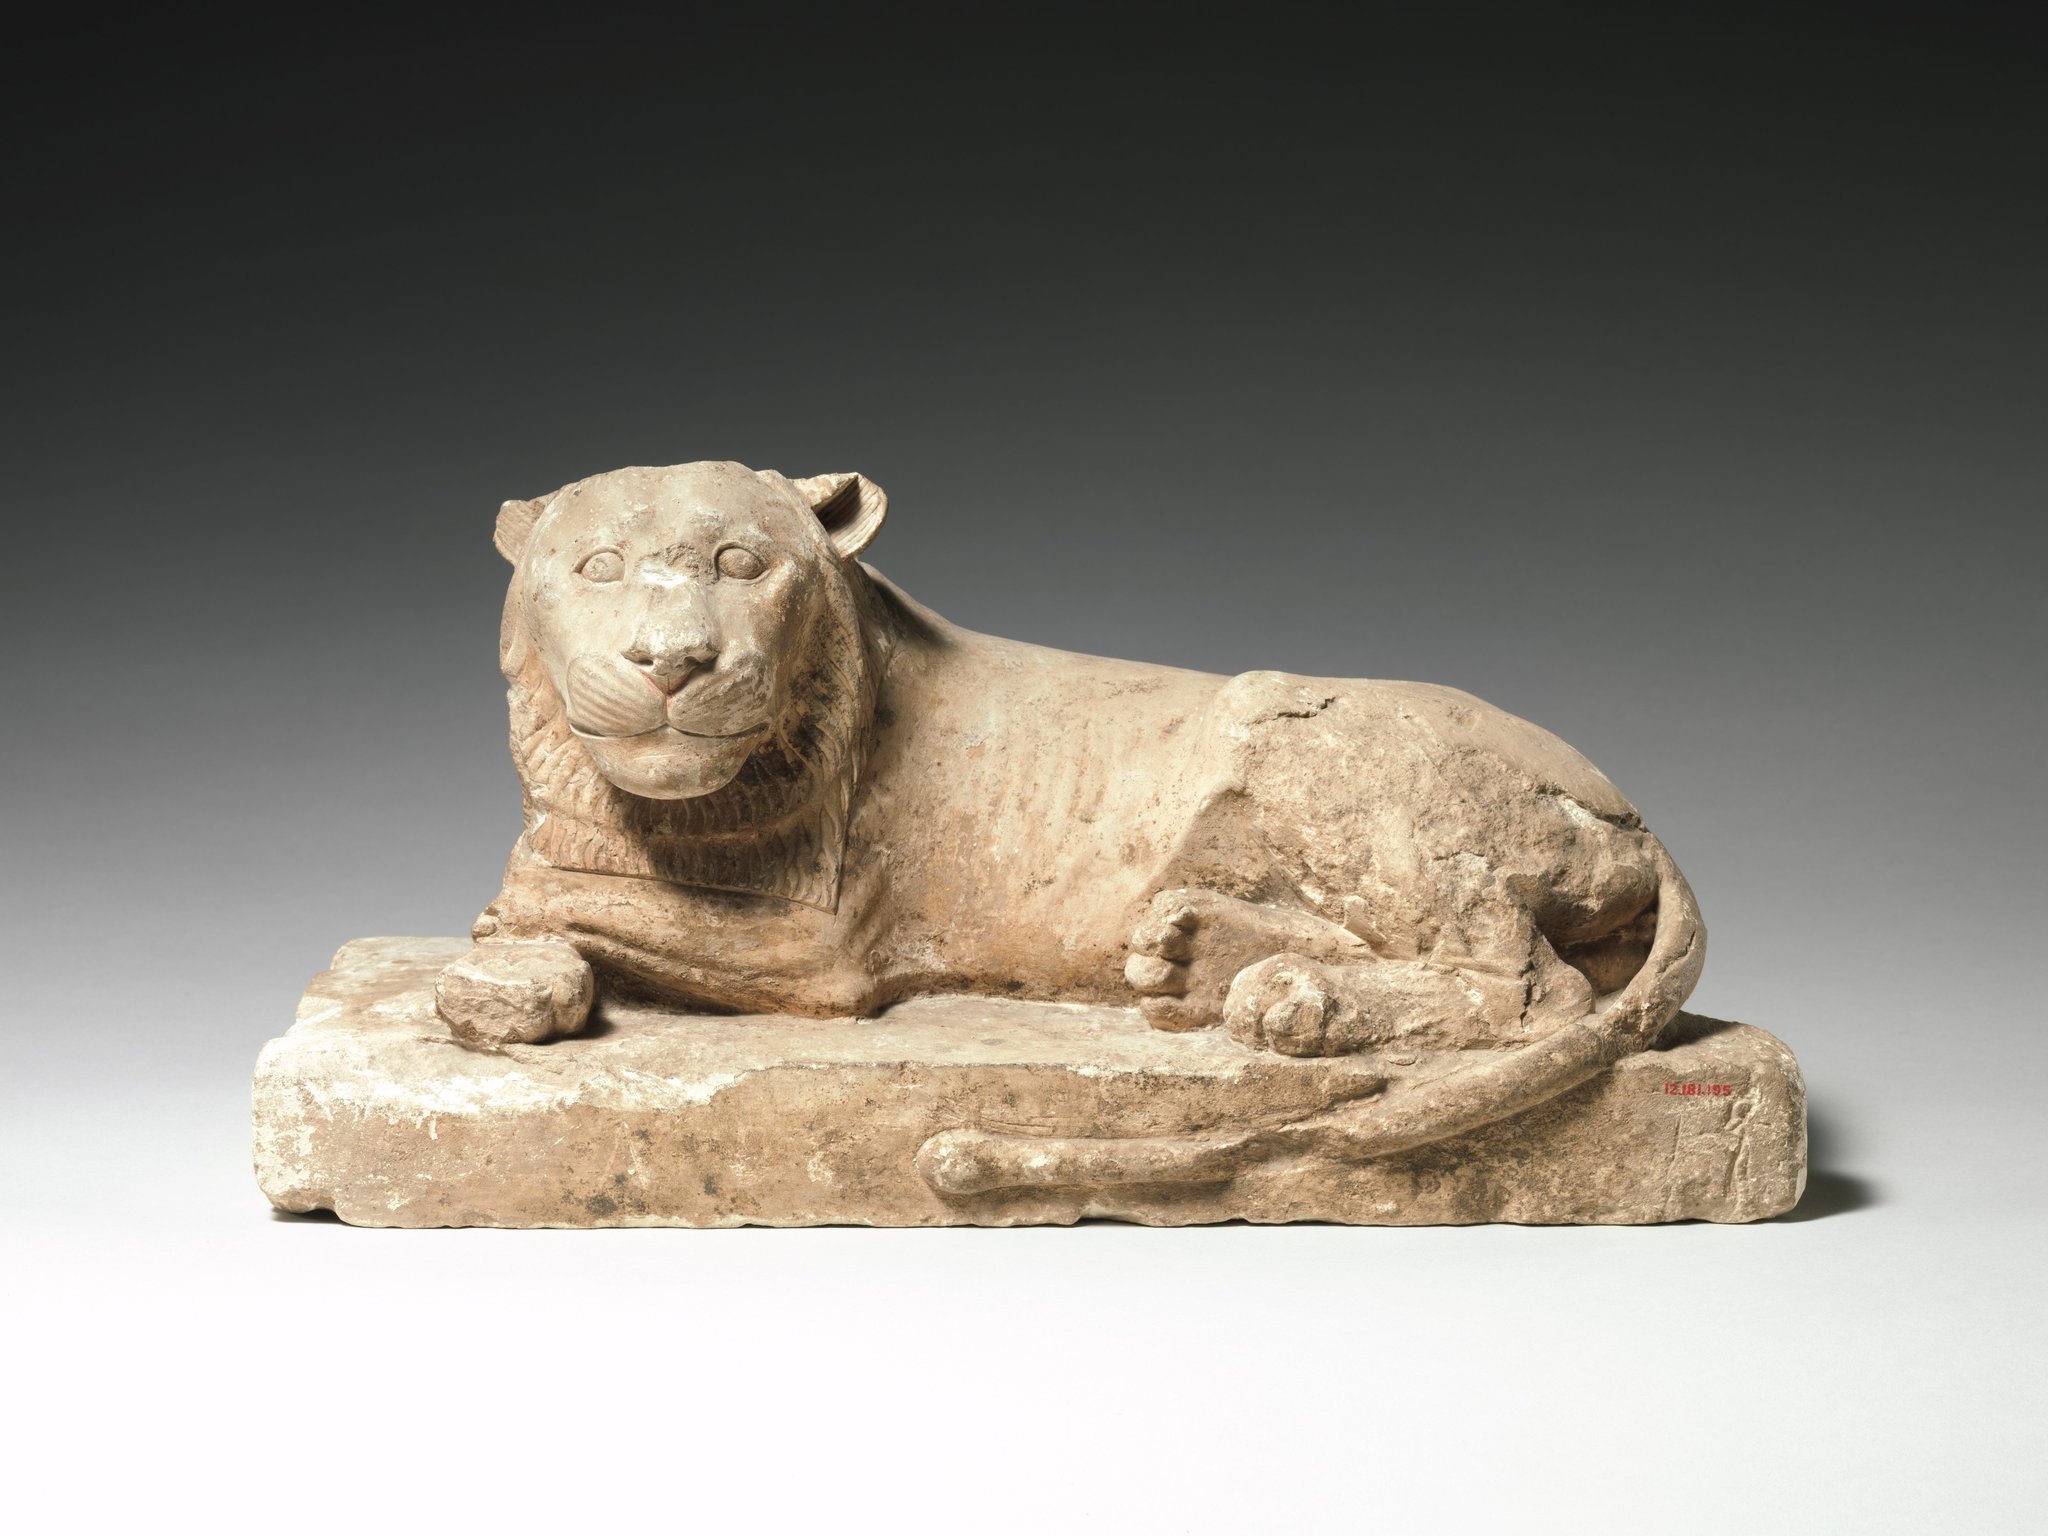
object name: statuette of a lion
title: Reclining lion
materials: limestone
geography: egypt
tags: lions